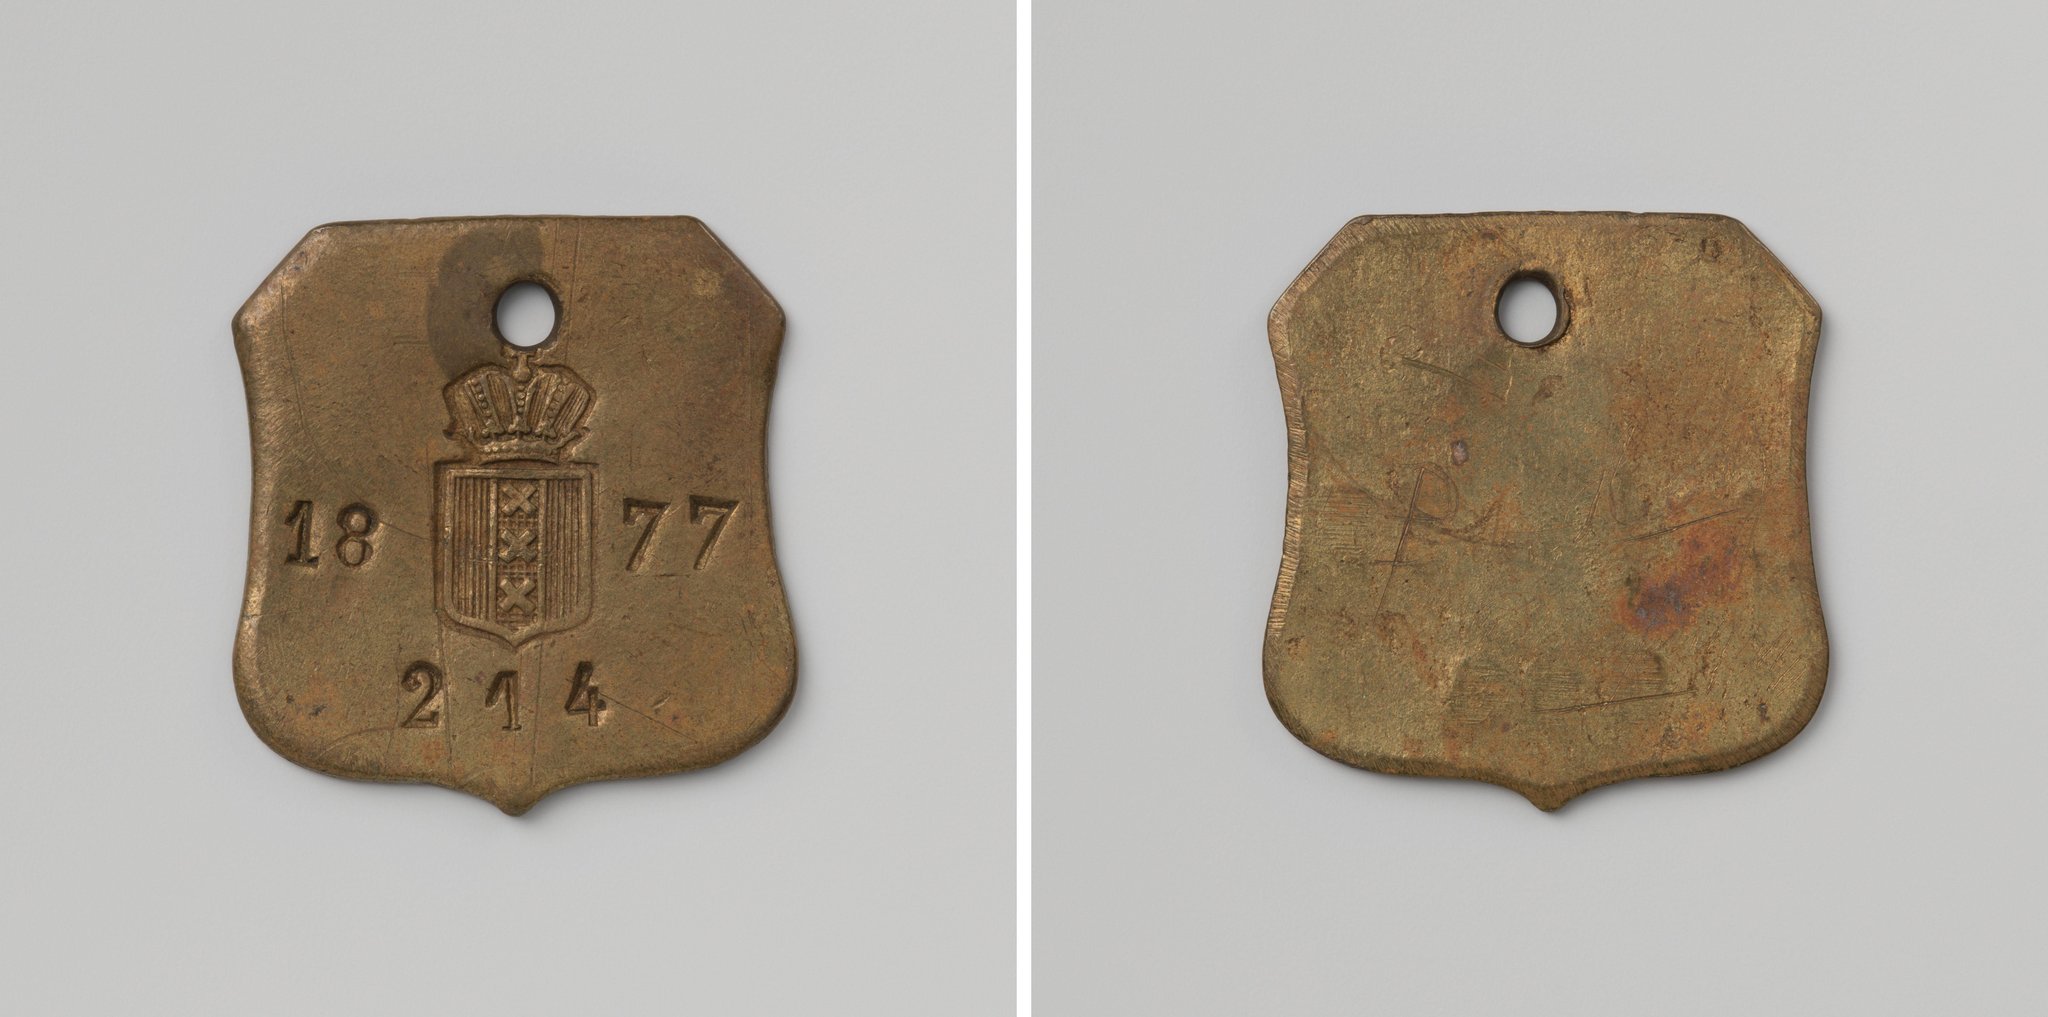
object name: hondenbelastingloodje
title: Stad Amsterdam, loodje met no. 214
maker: Anonymous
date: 1877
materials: brass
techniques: striking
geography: amsterdam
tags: amsterdam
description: eenzijdig, ruitvormig loodje met holle zijden, aan bovenzijde afgeschuinde hoeken en gat, en aan onderzijde afgeronde hoeken en eindigend in punt. Voorzijde: gekroond wapenschild tussen jaartal boven cijfer 214. Keerzijde: blanco